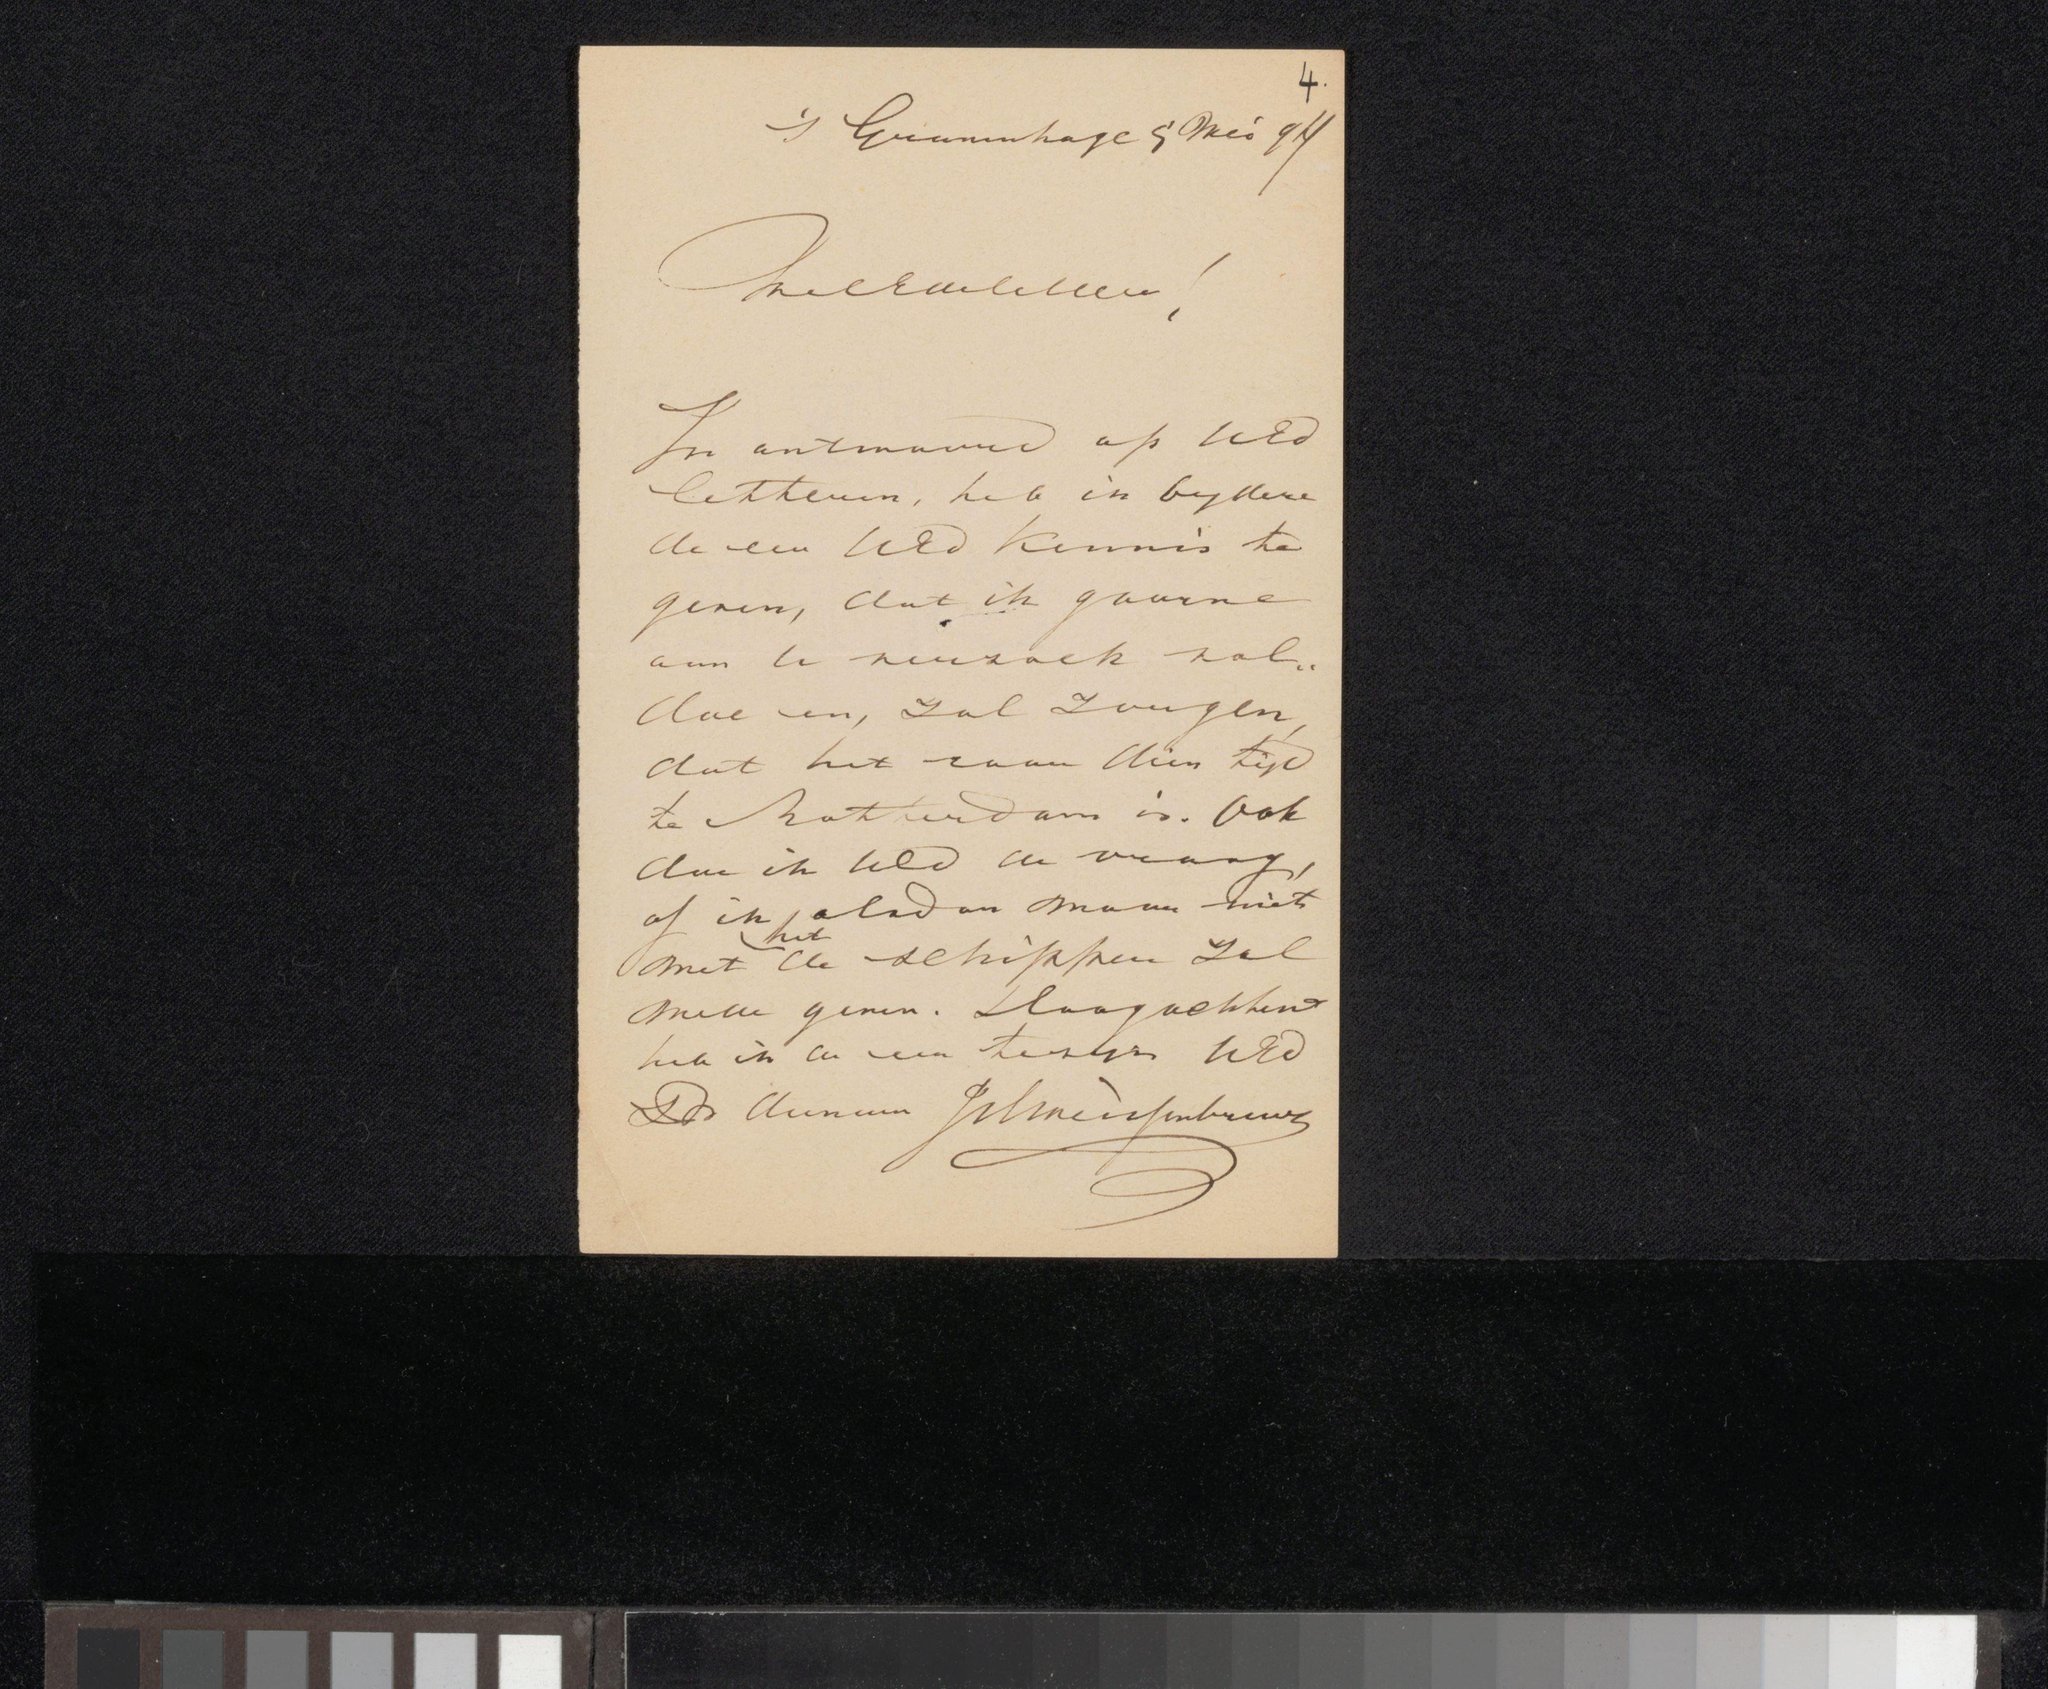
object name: letter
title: Brief aan Pieter Haverkorn van Rijsewijk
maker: johan hendrik weissenbruch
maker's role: draughtsman, painter, print maker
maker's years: 1824-1903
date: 1894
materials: ink, paper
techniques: pen, writing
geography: the hague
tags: pieter haverkorn van rijsewijk, rotterdam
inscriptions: watermark